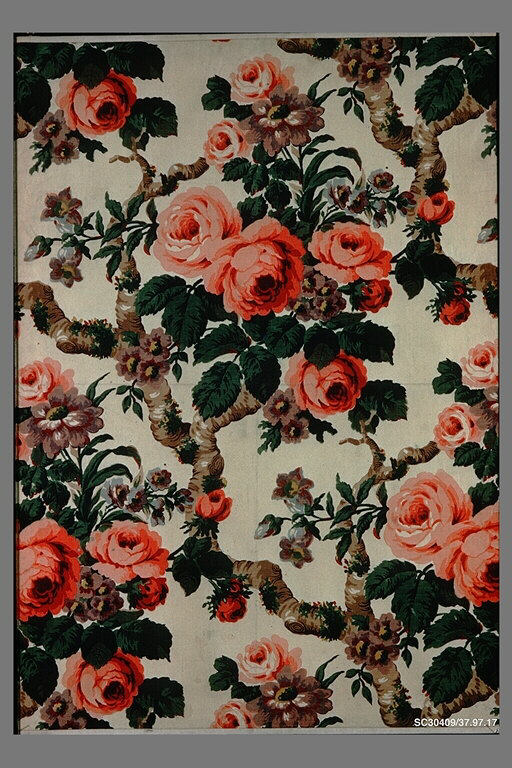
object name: piece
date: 1872-1886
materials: cotton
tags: roses,leaves